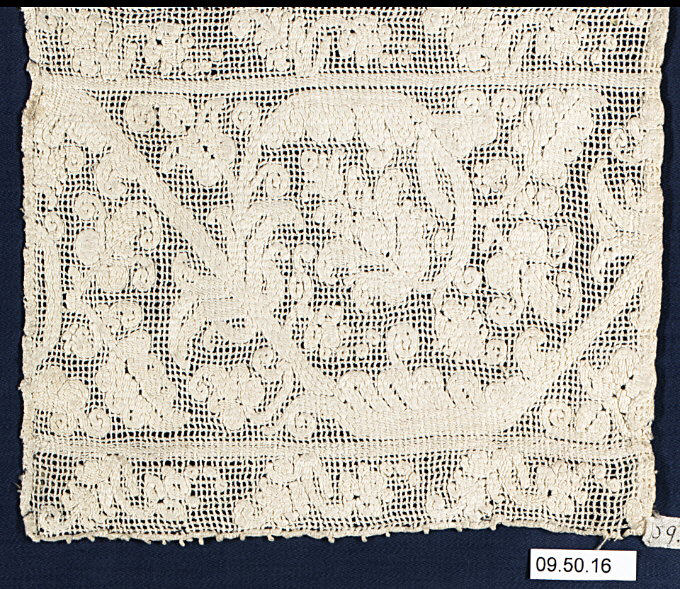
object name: fragment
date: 1601-1700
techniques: embroidery